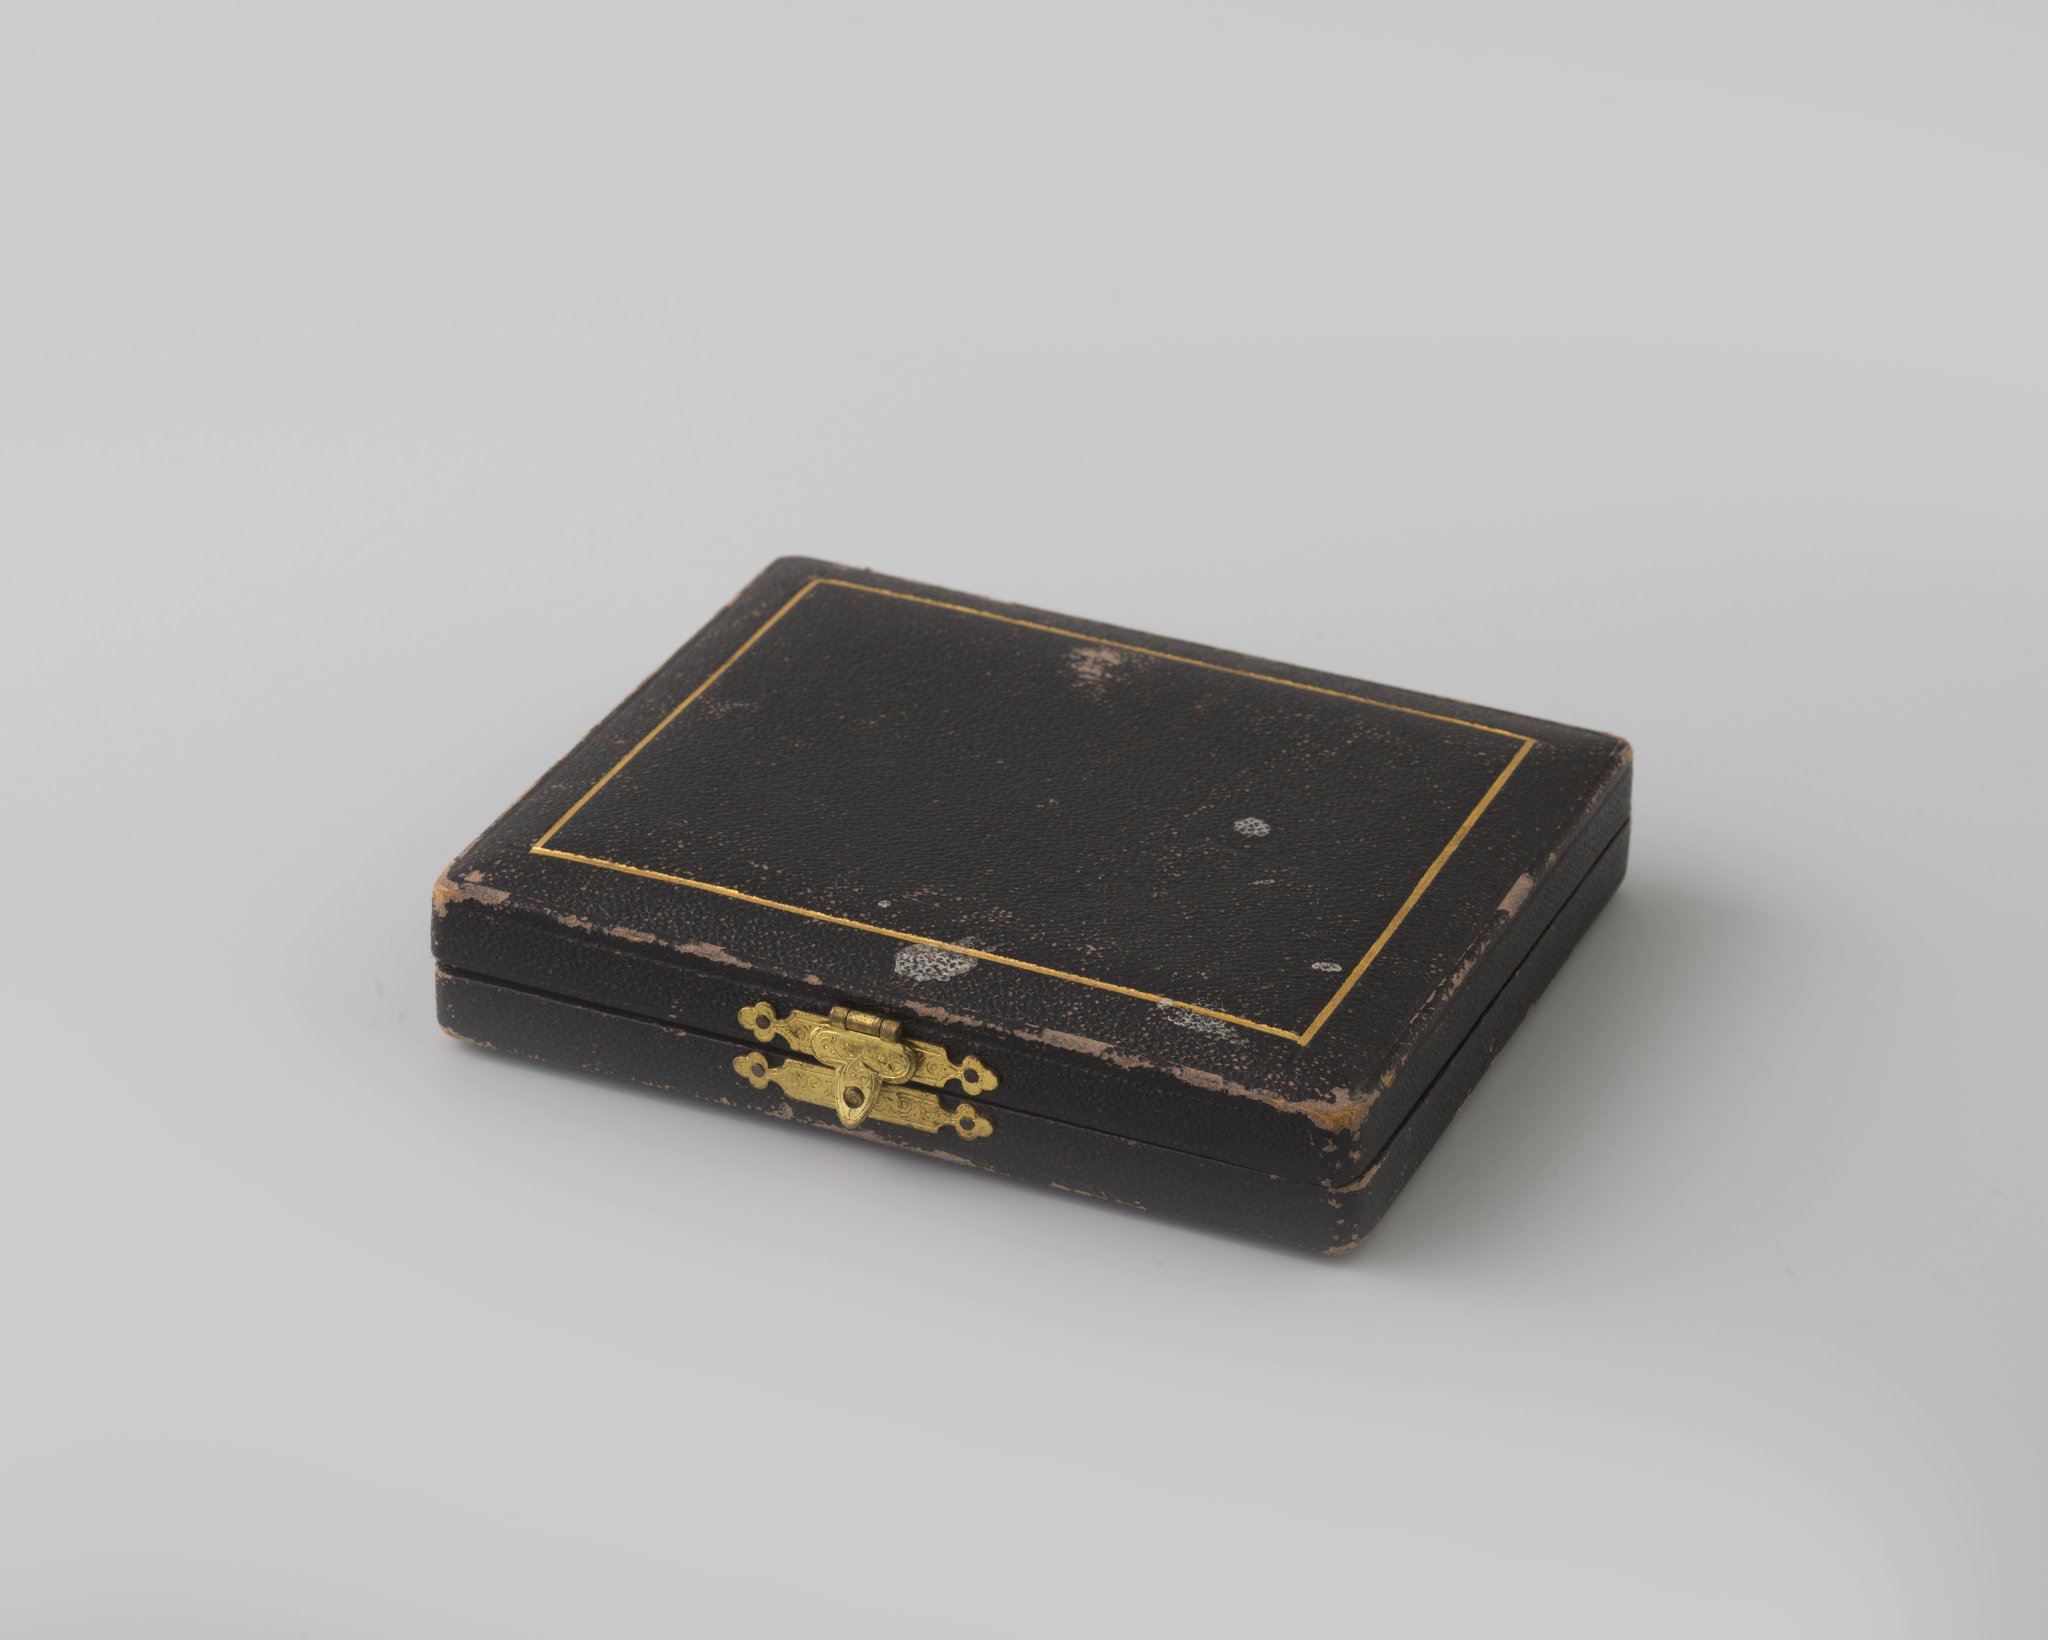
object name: juwelendoos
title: Vierkante met zwart leer beklede juwelendoos.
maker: Anonymous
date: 1902-1903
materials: leather, velvet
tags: trees: maple (+ parts of plants)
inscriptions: maker's mark, town mark, alloy mark, date letter: ‘C’, mark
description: Zwarte juwelendoos met op deksel een gouden rand.